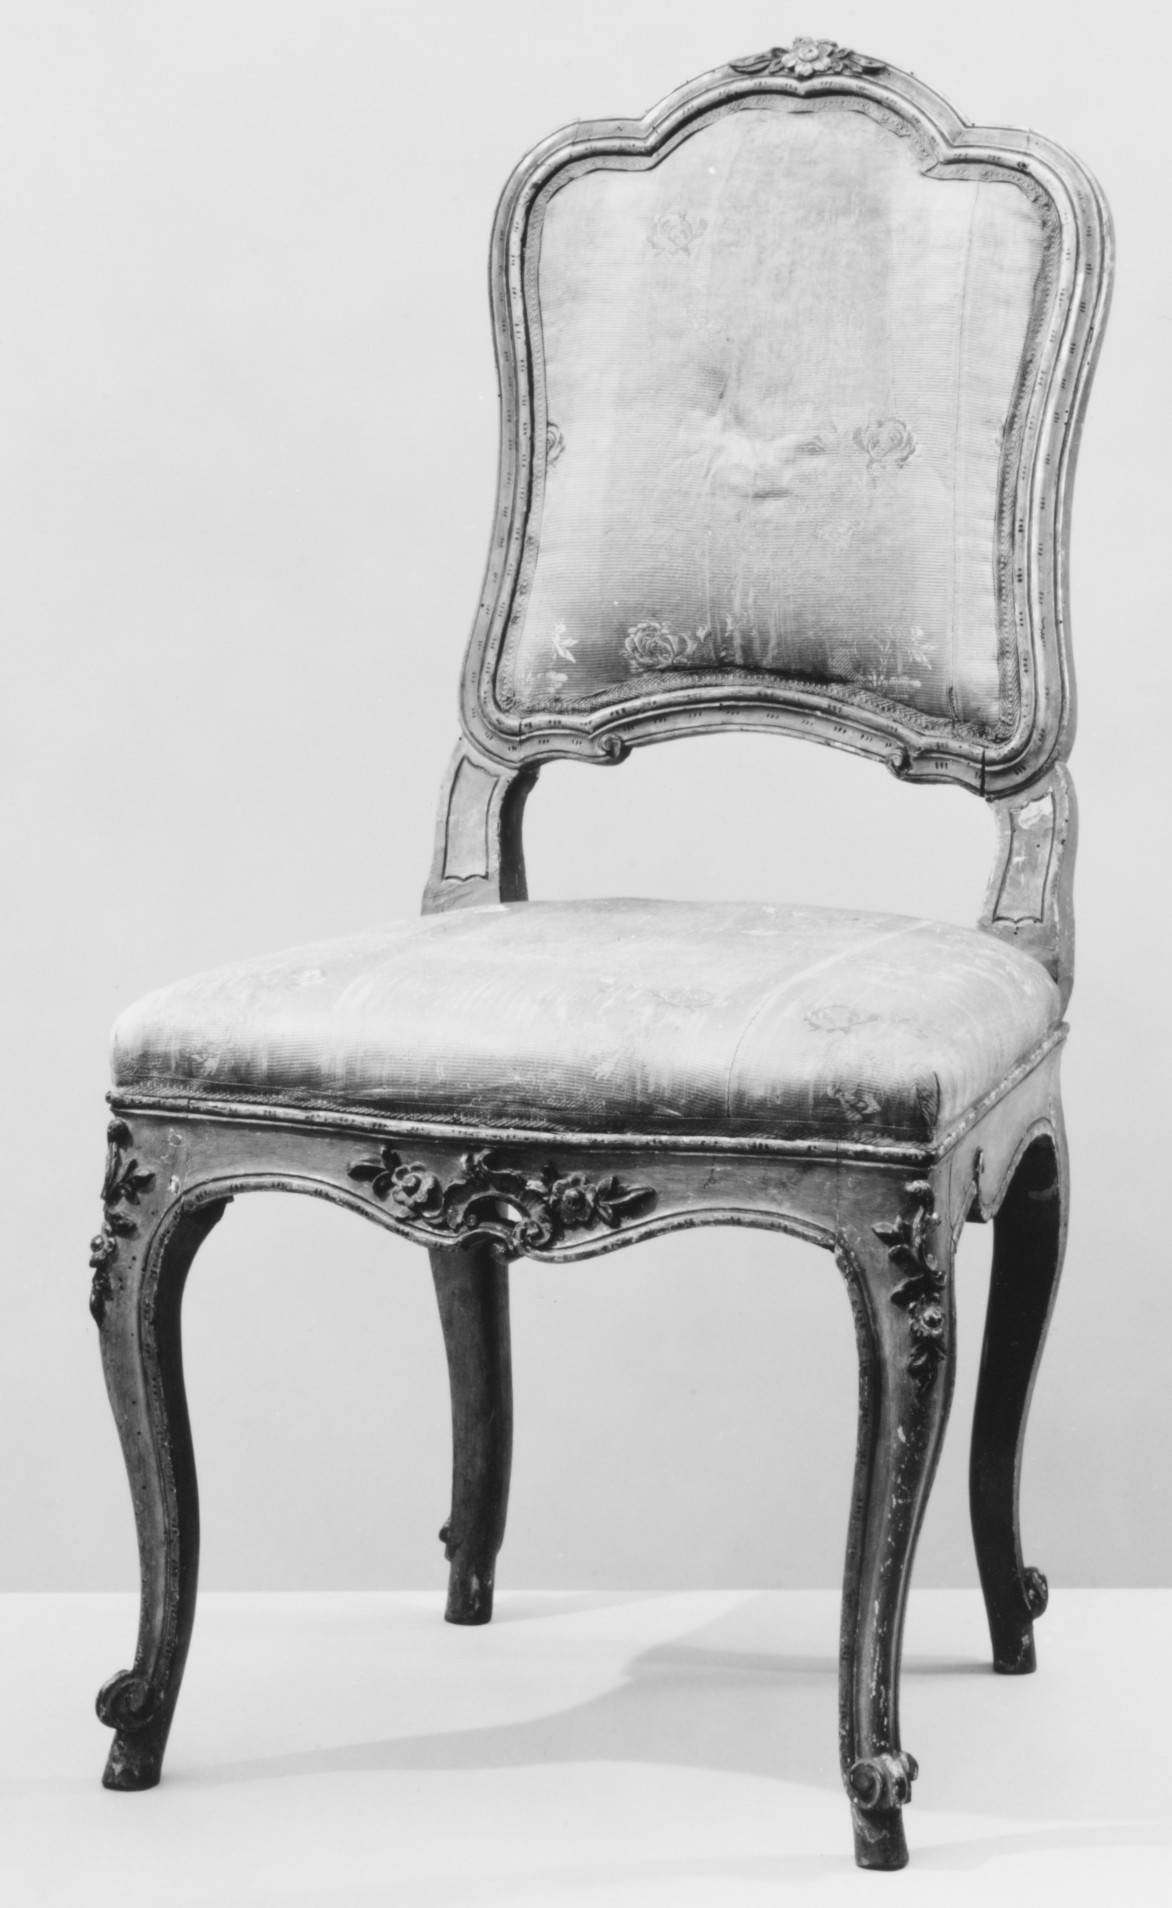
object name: side chair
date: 1701-1800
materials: wood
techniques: brocade, lacquer